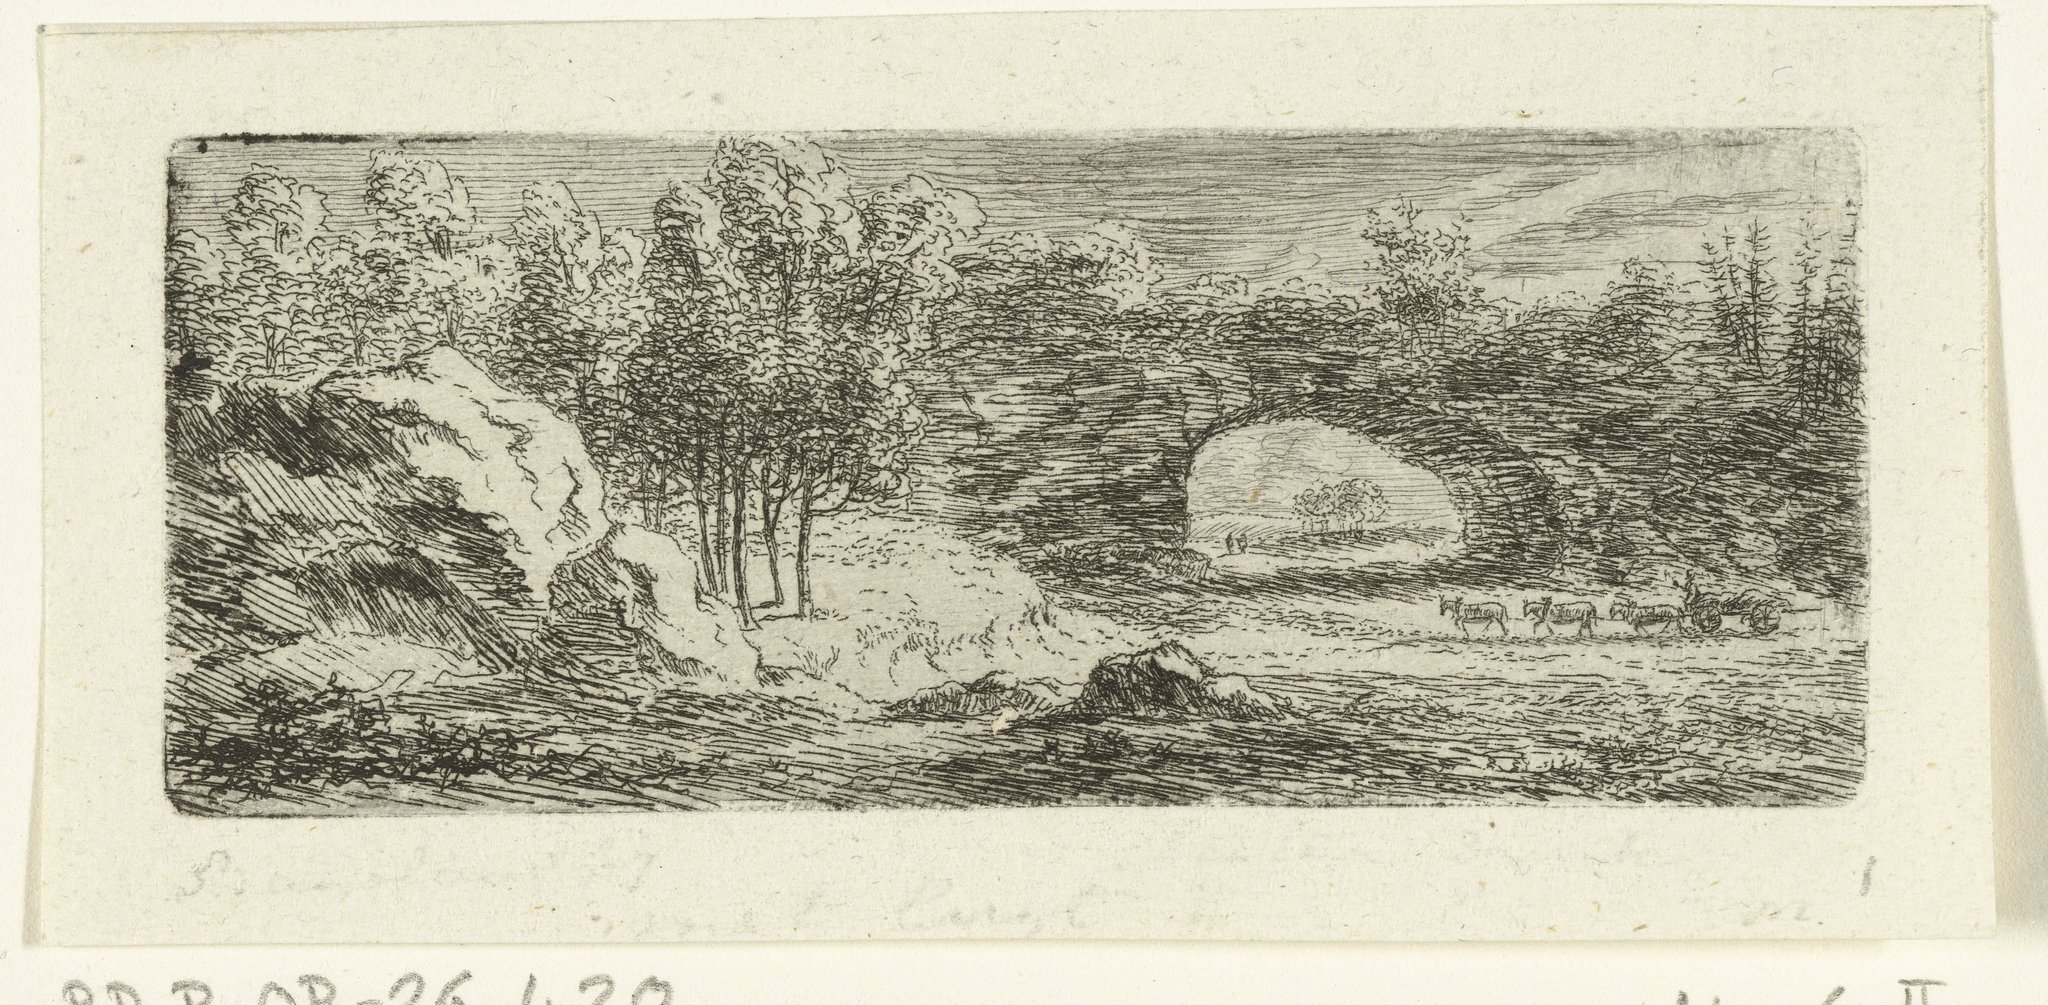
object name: print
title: Rotslandschap met natuurlijke brug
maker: ernst willem jan bagelaar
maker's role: draughtsman, print maker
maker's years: 1775-1837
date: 1798-1837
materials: paper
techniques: drypoint, etching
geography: netherlands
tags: rock-formations